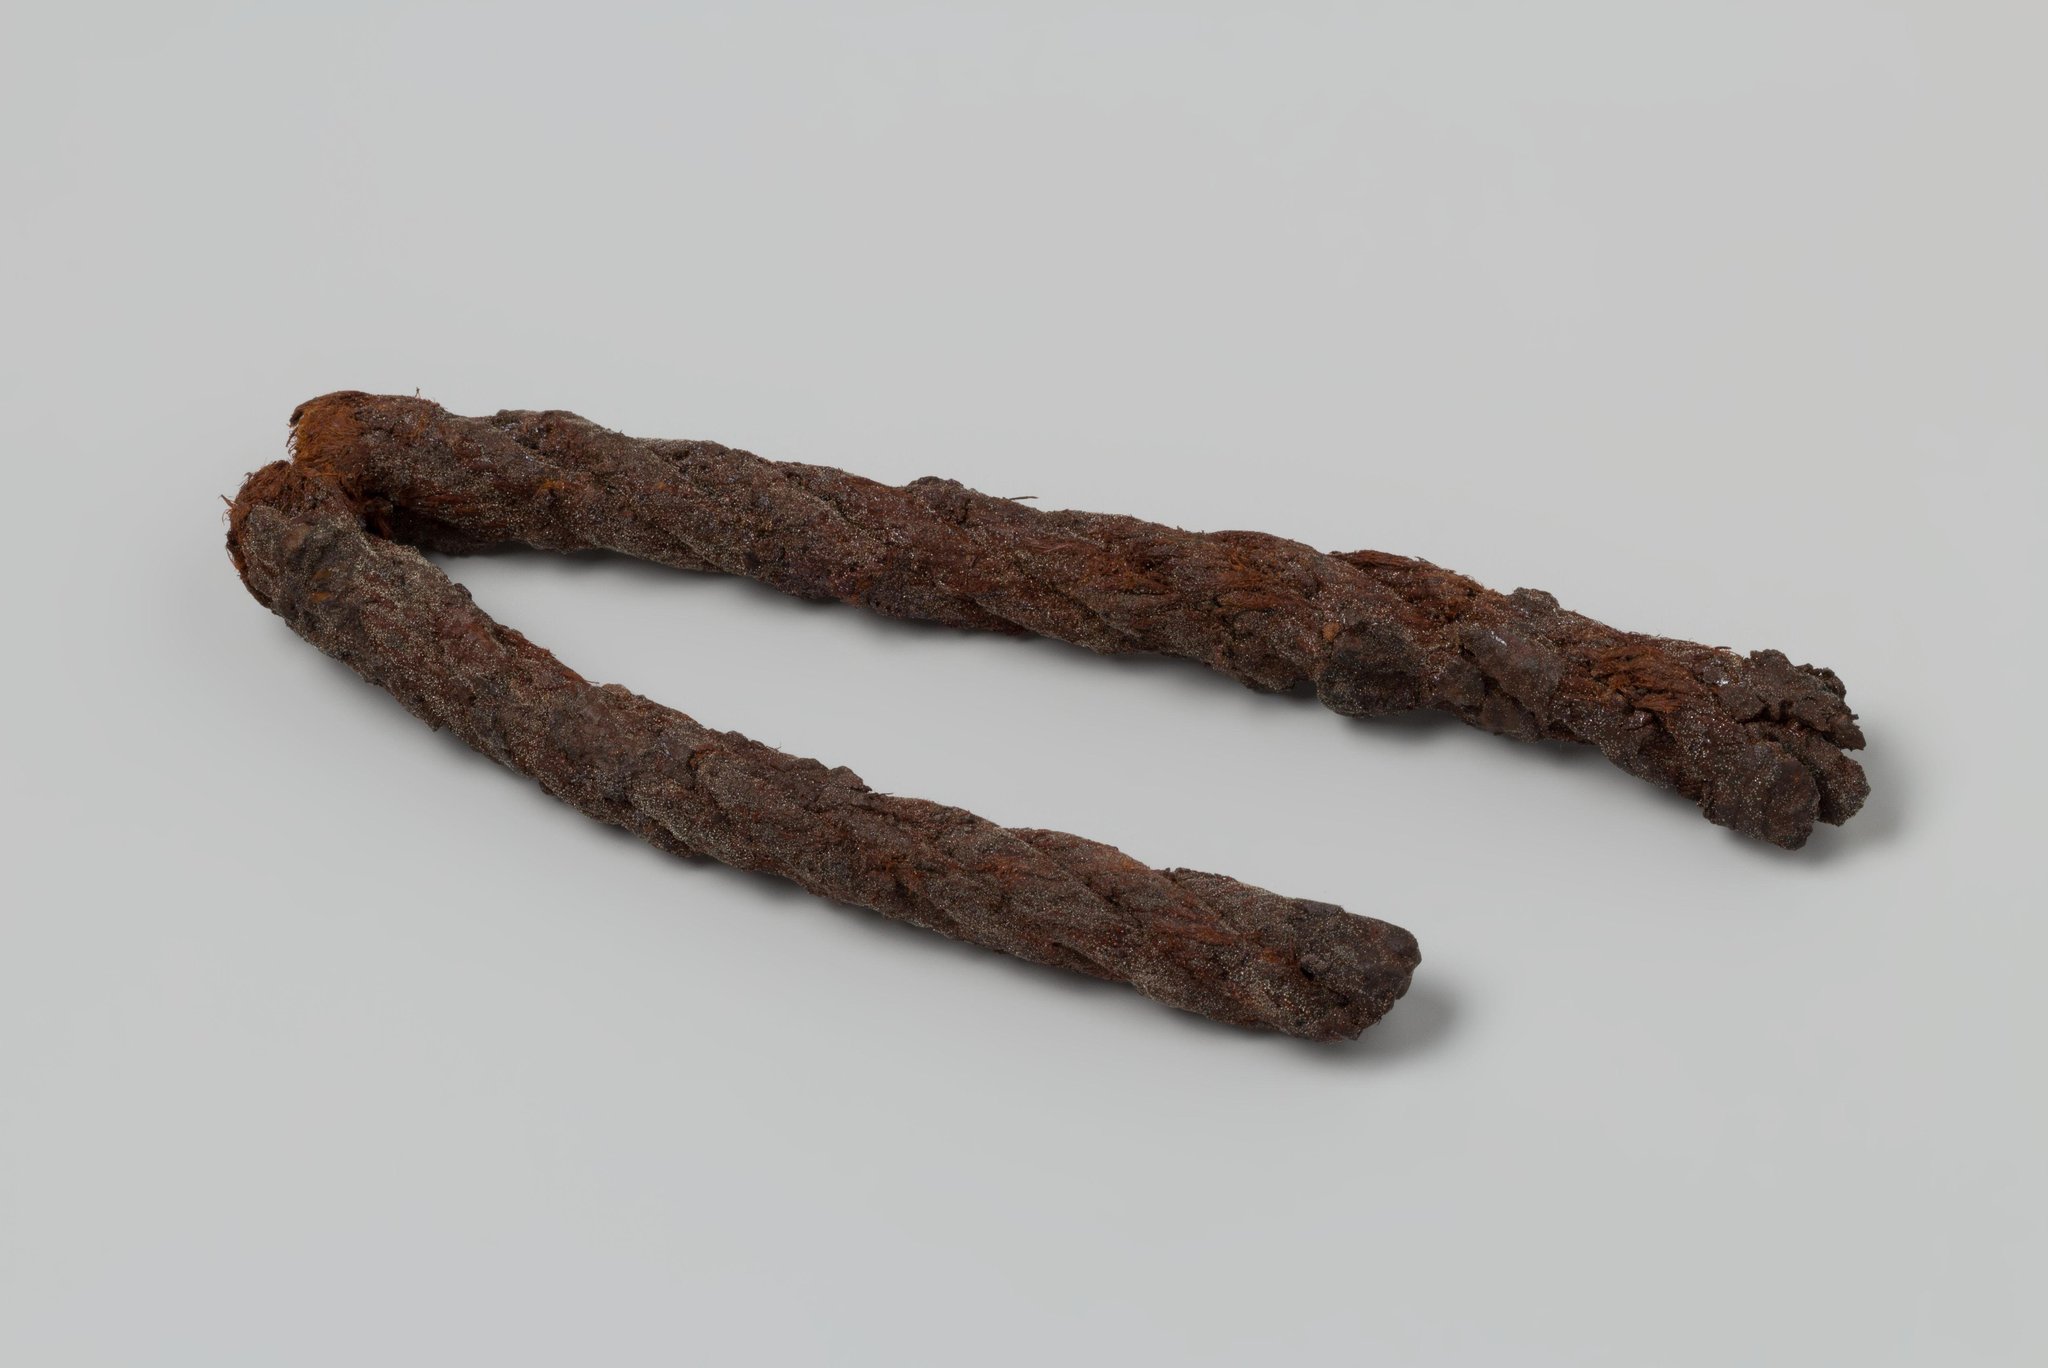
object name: rope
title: Touwfragment uit het wrak van de in 1735 vergane Oost-Indiëvaarder 't Vliegend Hart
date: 1700-1735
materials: hemp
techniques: striking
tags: 't vliegend hart (schip), verenigde oostindische compagnie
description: Stuk touw, bruin, vrij dun, bestaand uit vier strengen, gebroken op 14/18 cm. Rope.